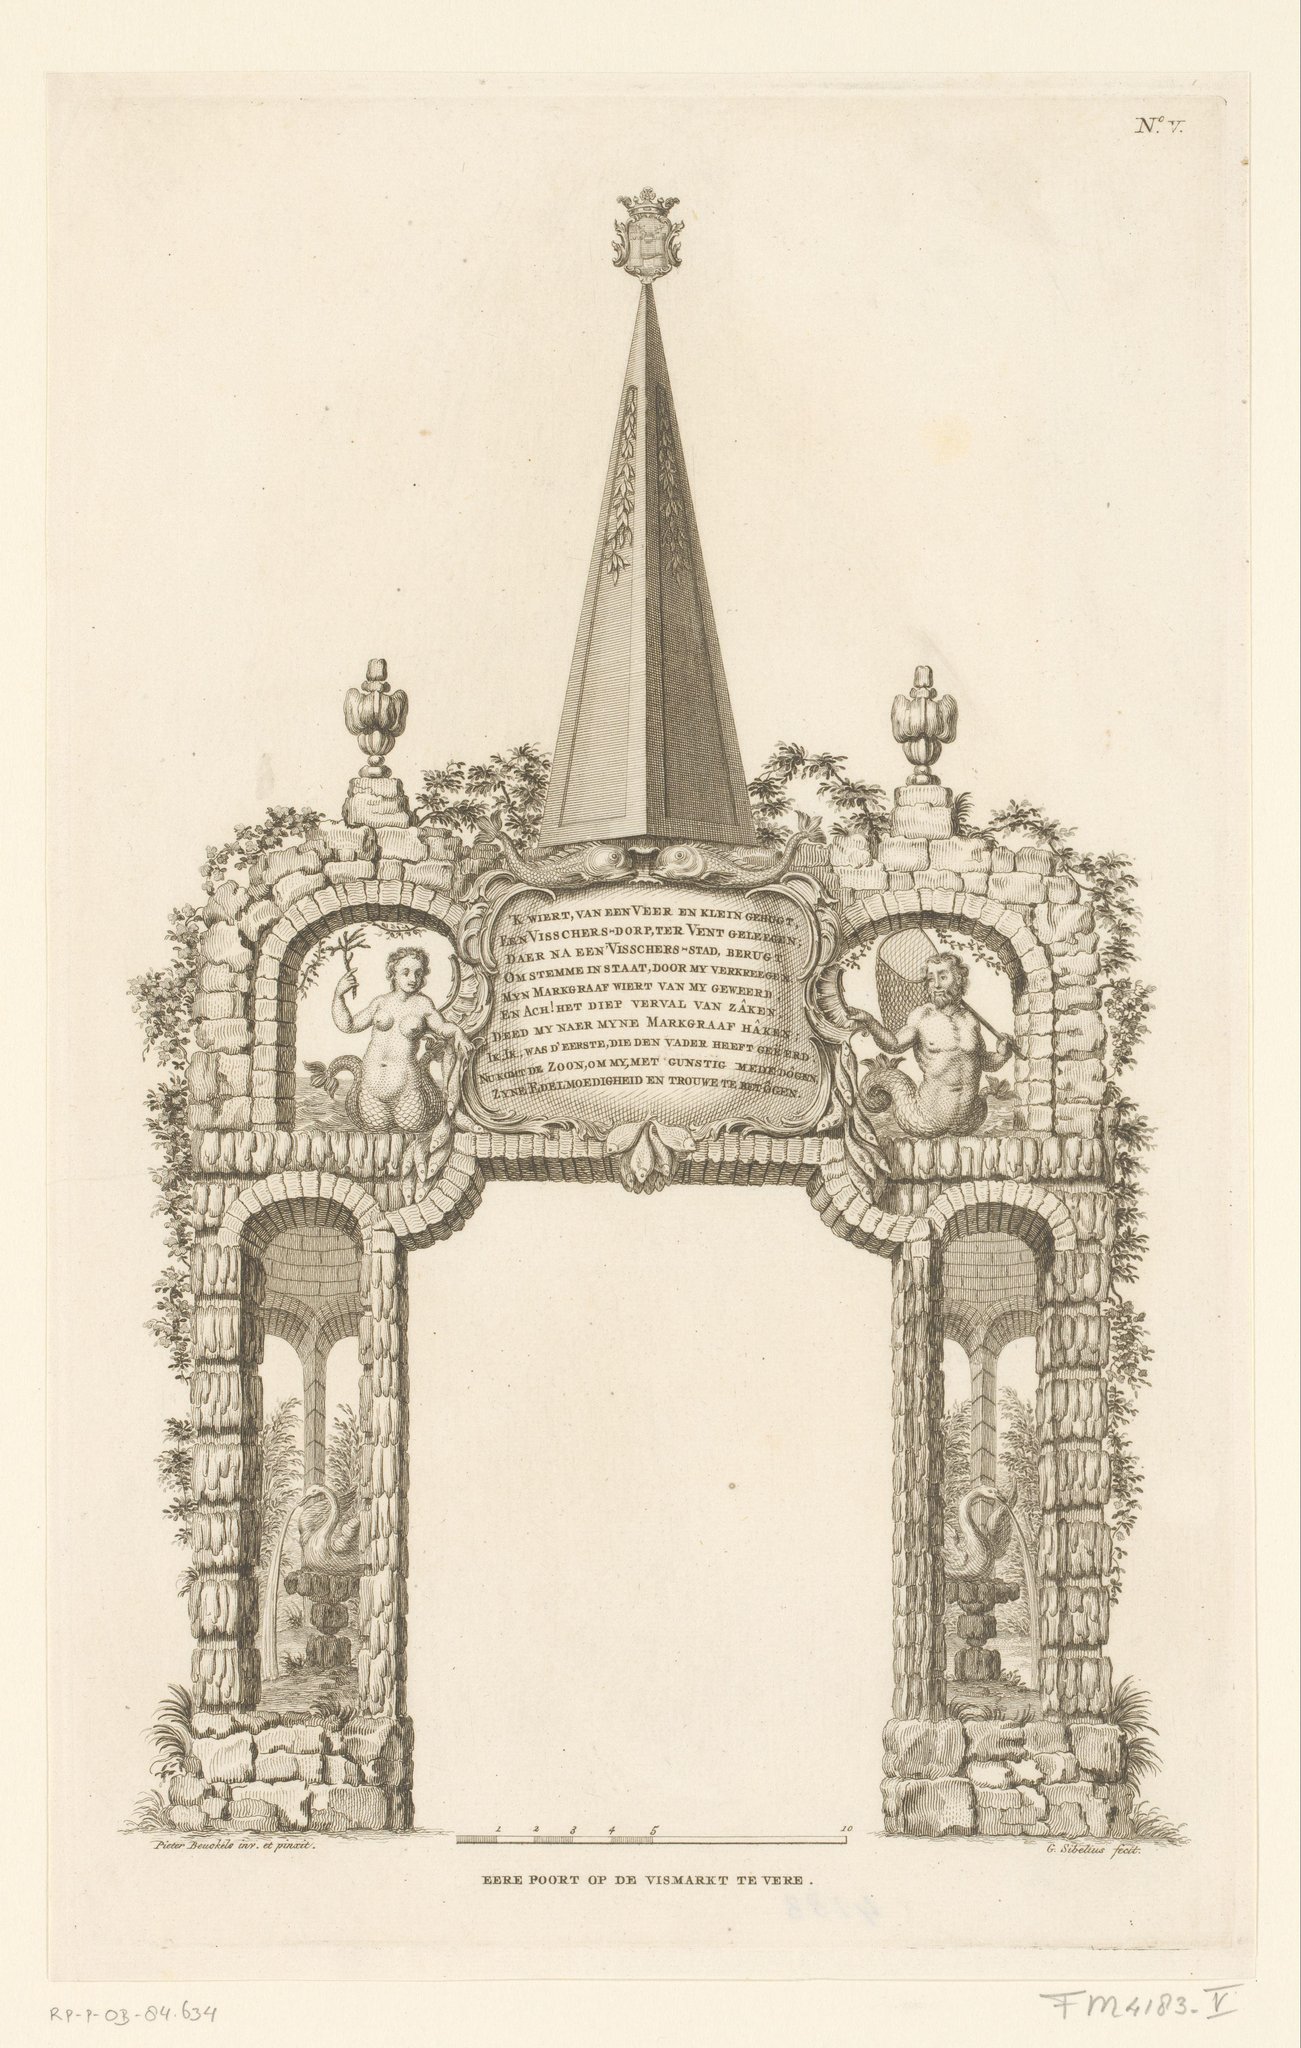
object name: print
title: Eere Poort op de Vismarkt te Vere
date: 1766-1767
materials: paper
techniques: engraving, etching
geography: northern netherlands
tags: the hague, william v (prince of orange), merman, merman - aa - mermaid, siren, triumphal arch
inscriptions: collector's mark: Lugt 2228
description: De erepoort opgericht op de Vismarkt te Veere. Bovenin een vers met aan weerszijden een zeemeermin en een zeemeerman. Onderdeel van een groep van 10 platen van de decoraties te Veere ter gelegenheid van de inhuldiging van stadhouder Willem V als Markgraaf van Veere, 28 mei 1766. Genummerd rechtsboven: No. V.